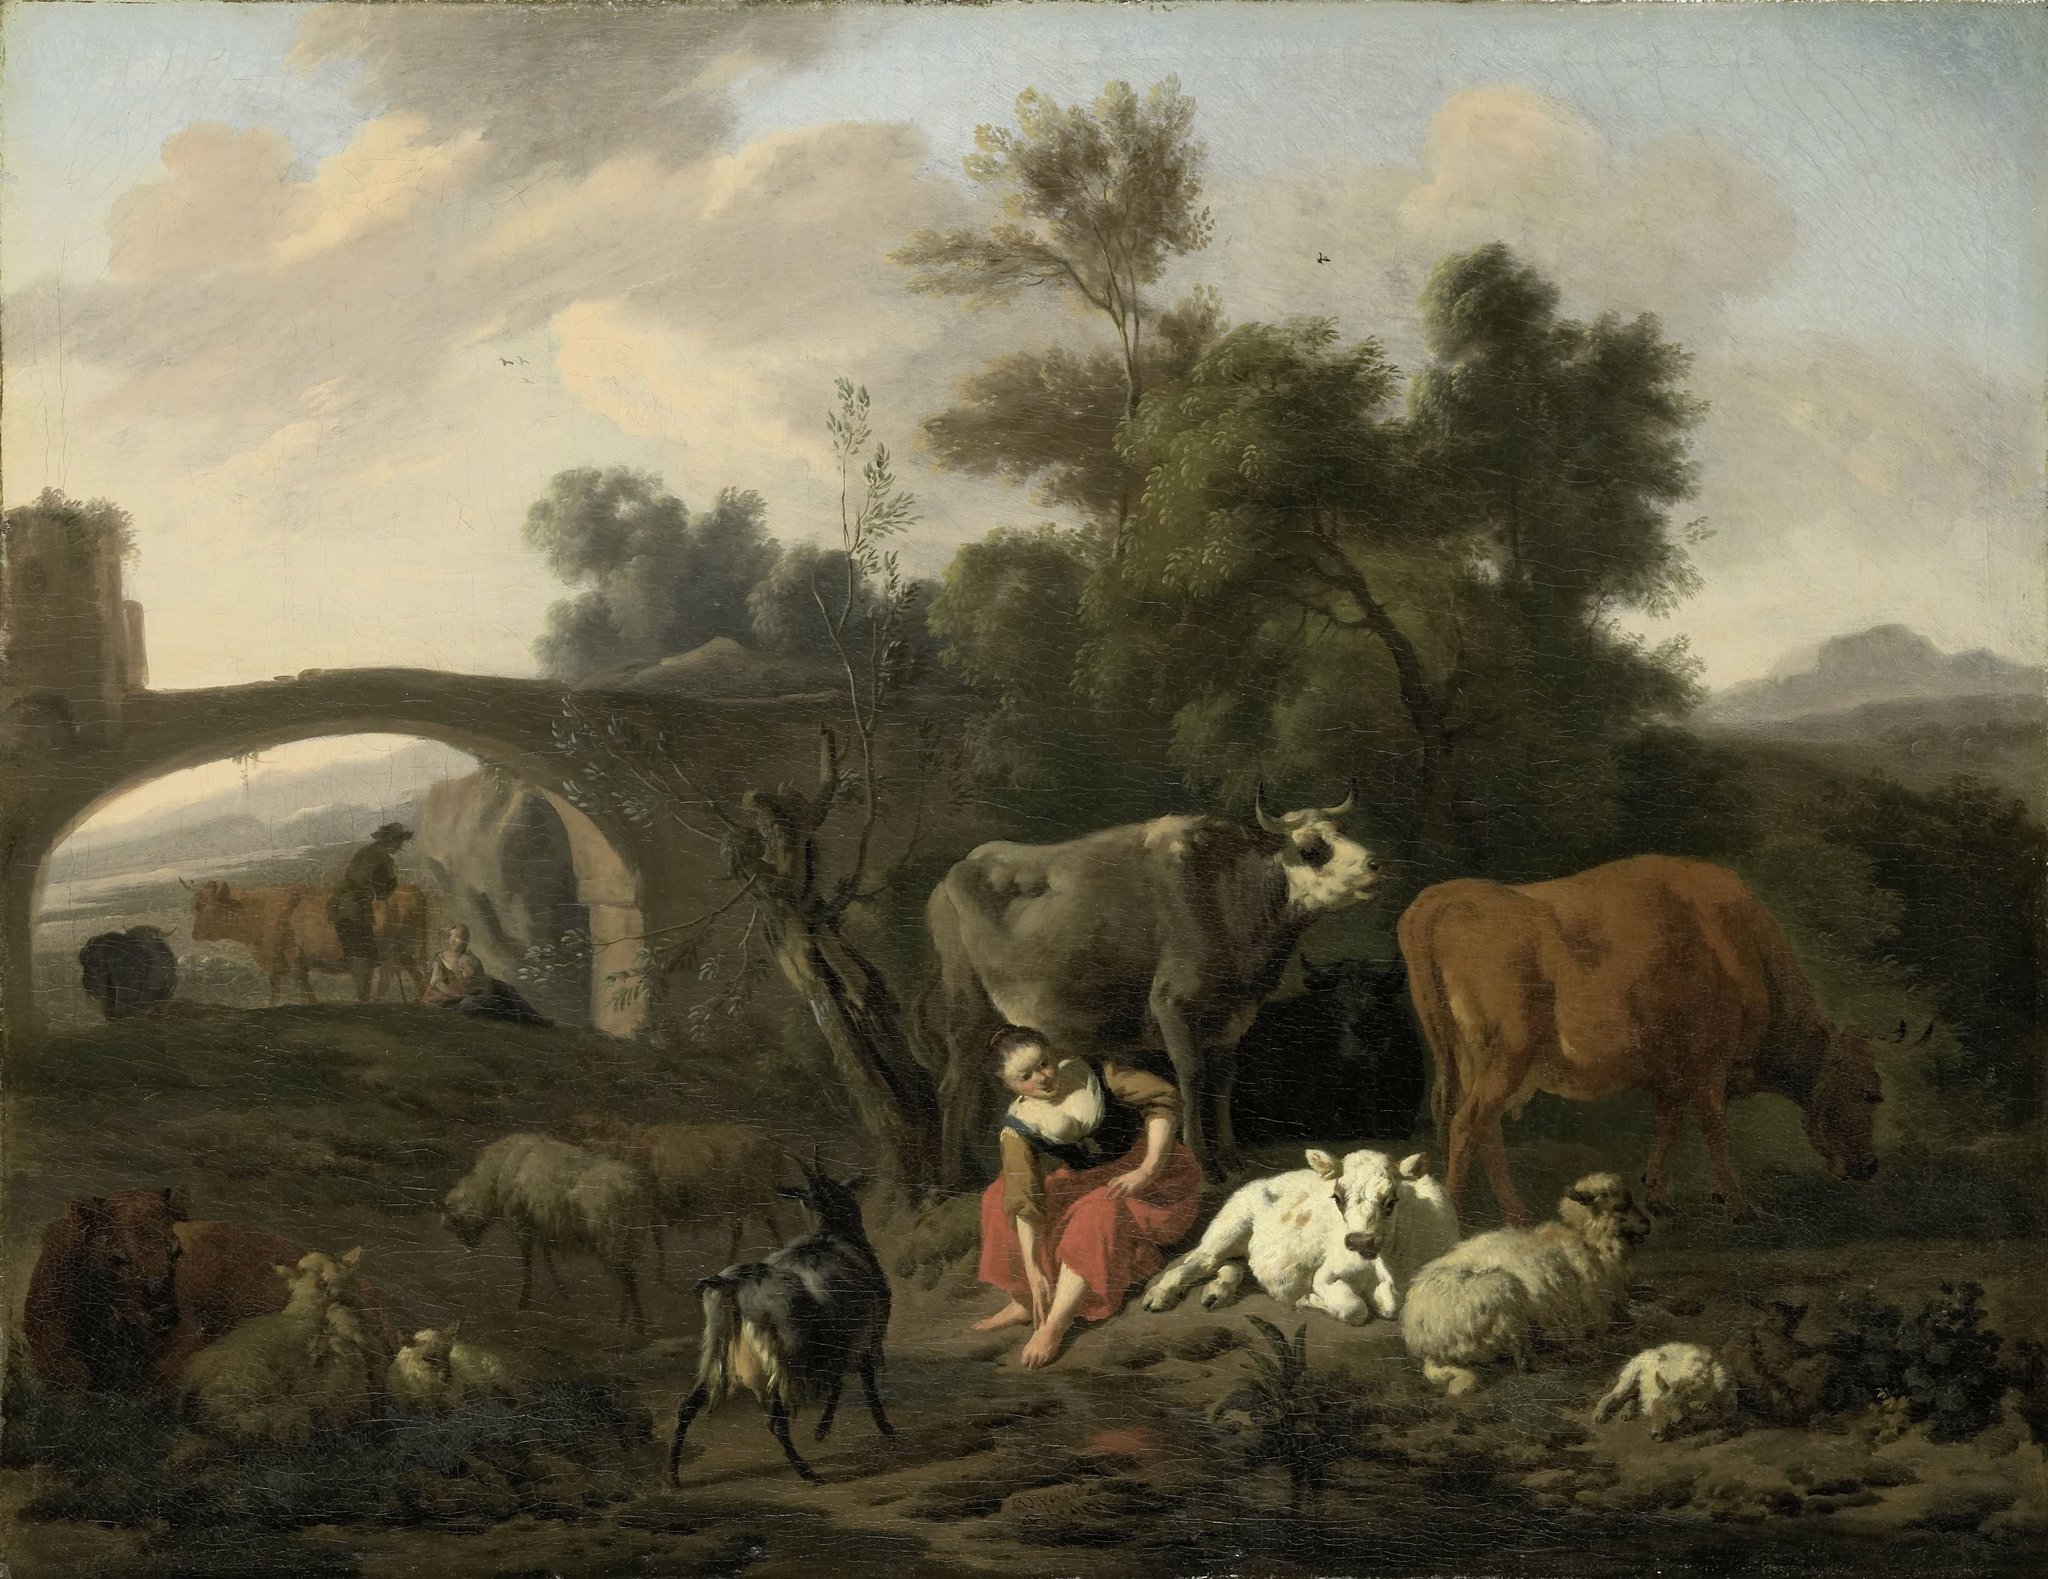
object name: painting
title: Landscape with Herdsmen and Cattle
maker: dirck van bergen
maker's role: painter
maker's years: 1645-1690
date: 1660-1690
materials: canvas, oil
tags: herding, herdsman, herdswoman, shepherd, shepherdess, cowherd, etc.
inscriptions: signature: ‘D.vand. Bergen’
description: Italiaans landschap met herders en vee, links een stenen brug.